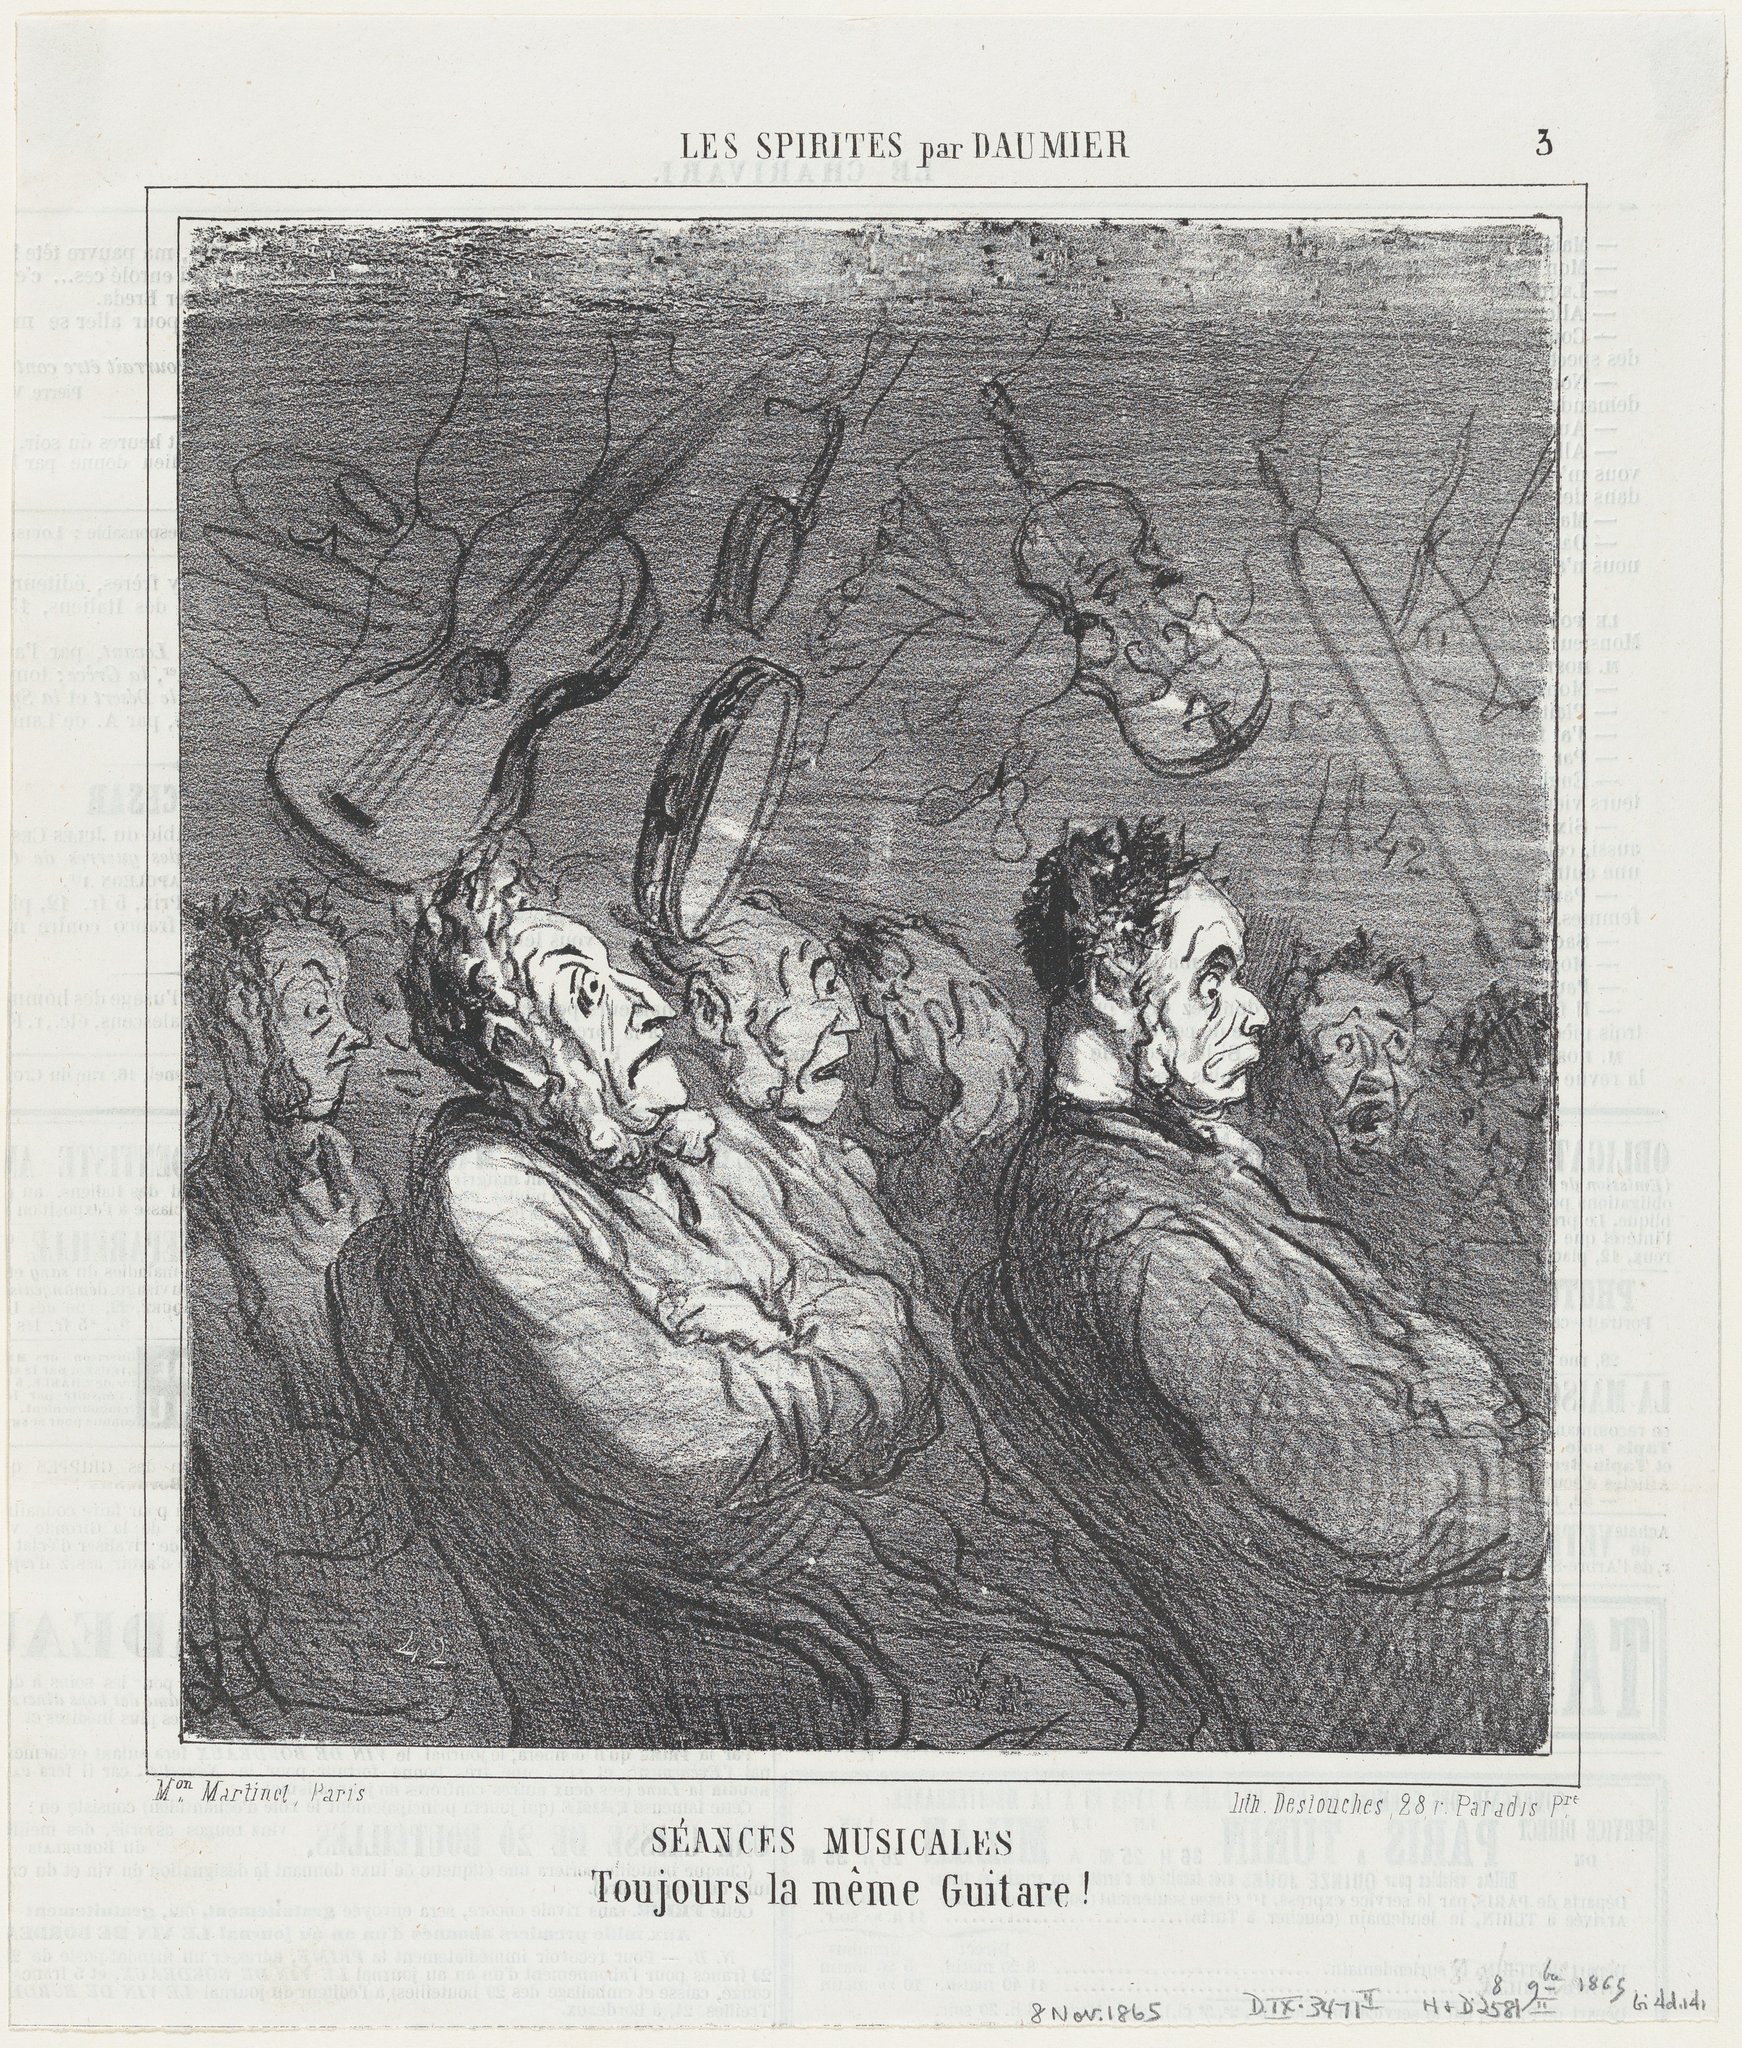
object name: print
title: Musical séances, always the same song!, from 'The spiritualists,' published in Le Charivari, November 8, 1865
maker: honoré daumier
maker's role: artist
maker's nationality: french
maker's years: 1808-1879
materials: paper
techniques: lithograph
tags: musical instruments,men